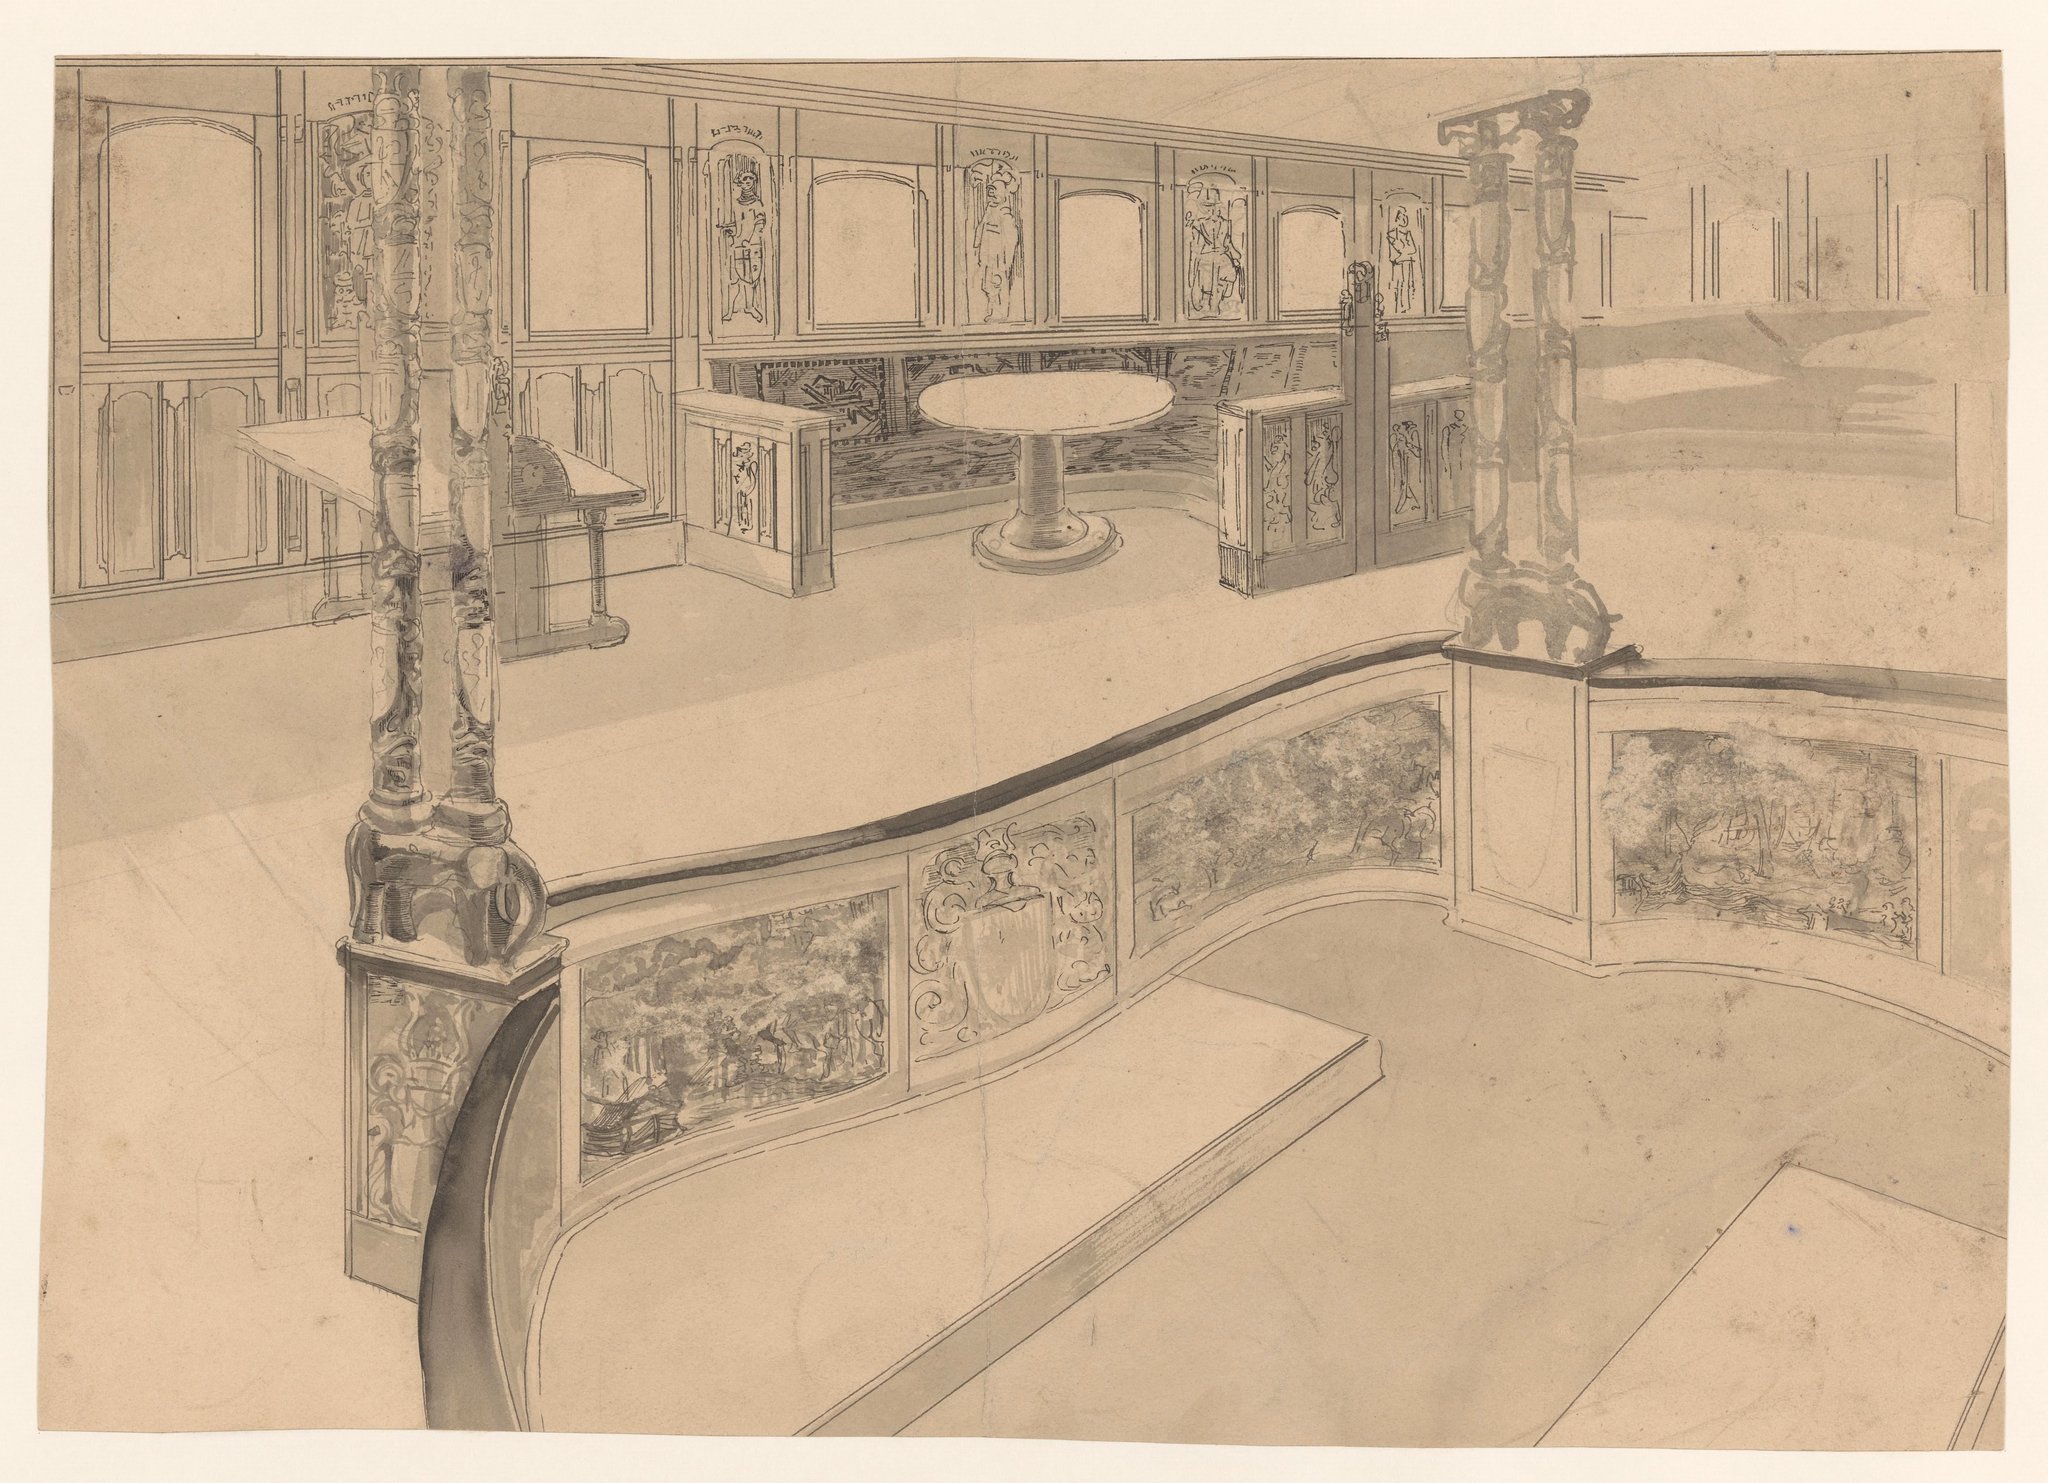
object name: drawing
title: Ontwerp voor het interieur van een deksalon met dichte balustrade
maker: carel adolph lion cachet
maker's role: draughtsman, print maker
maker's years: 1864-1945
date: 1874-1945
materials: ink, paper, pencil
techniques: brush, pen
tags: interior of the house, parts of ship's interior